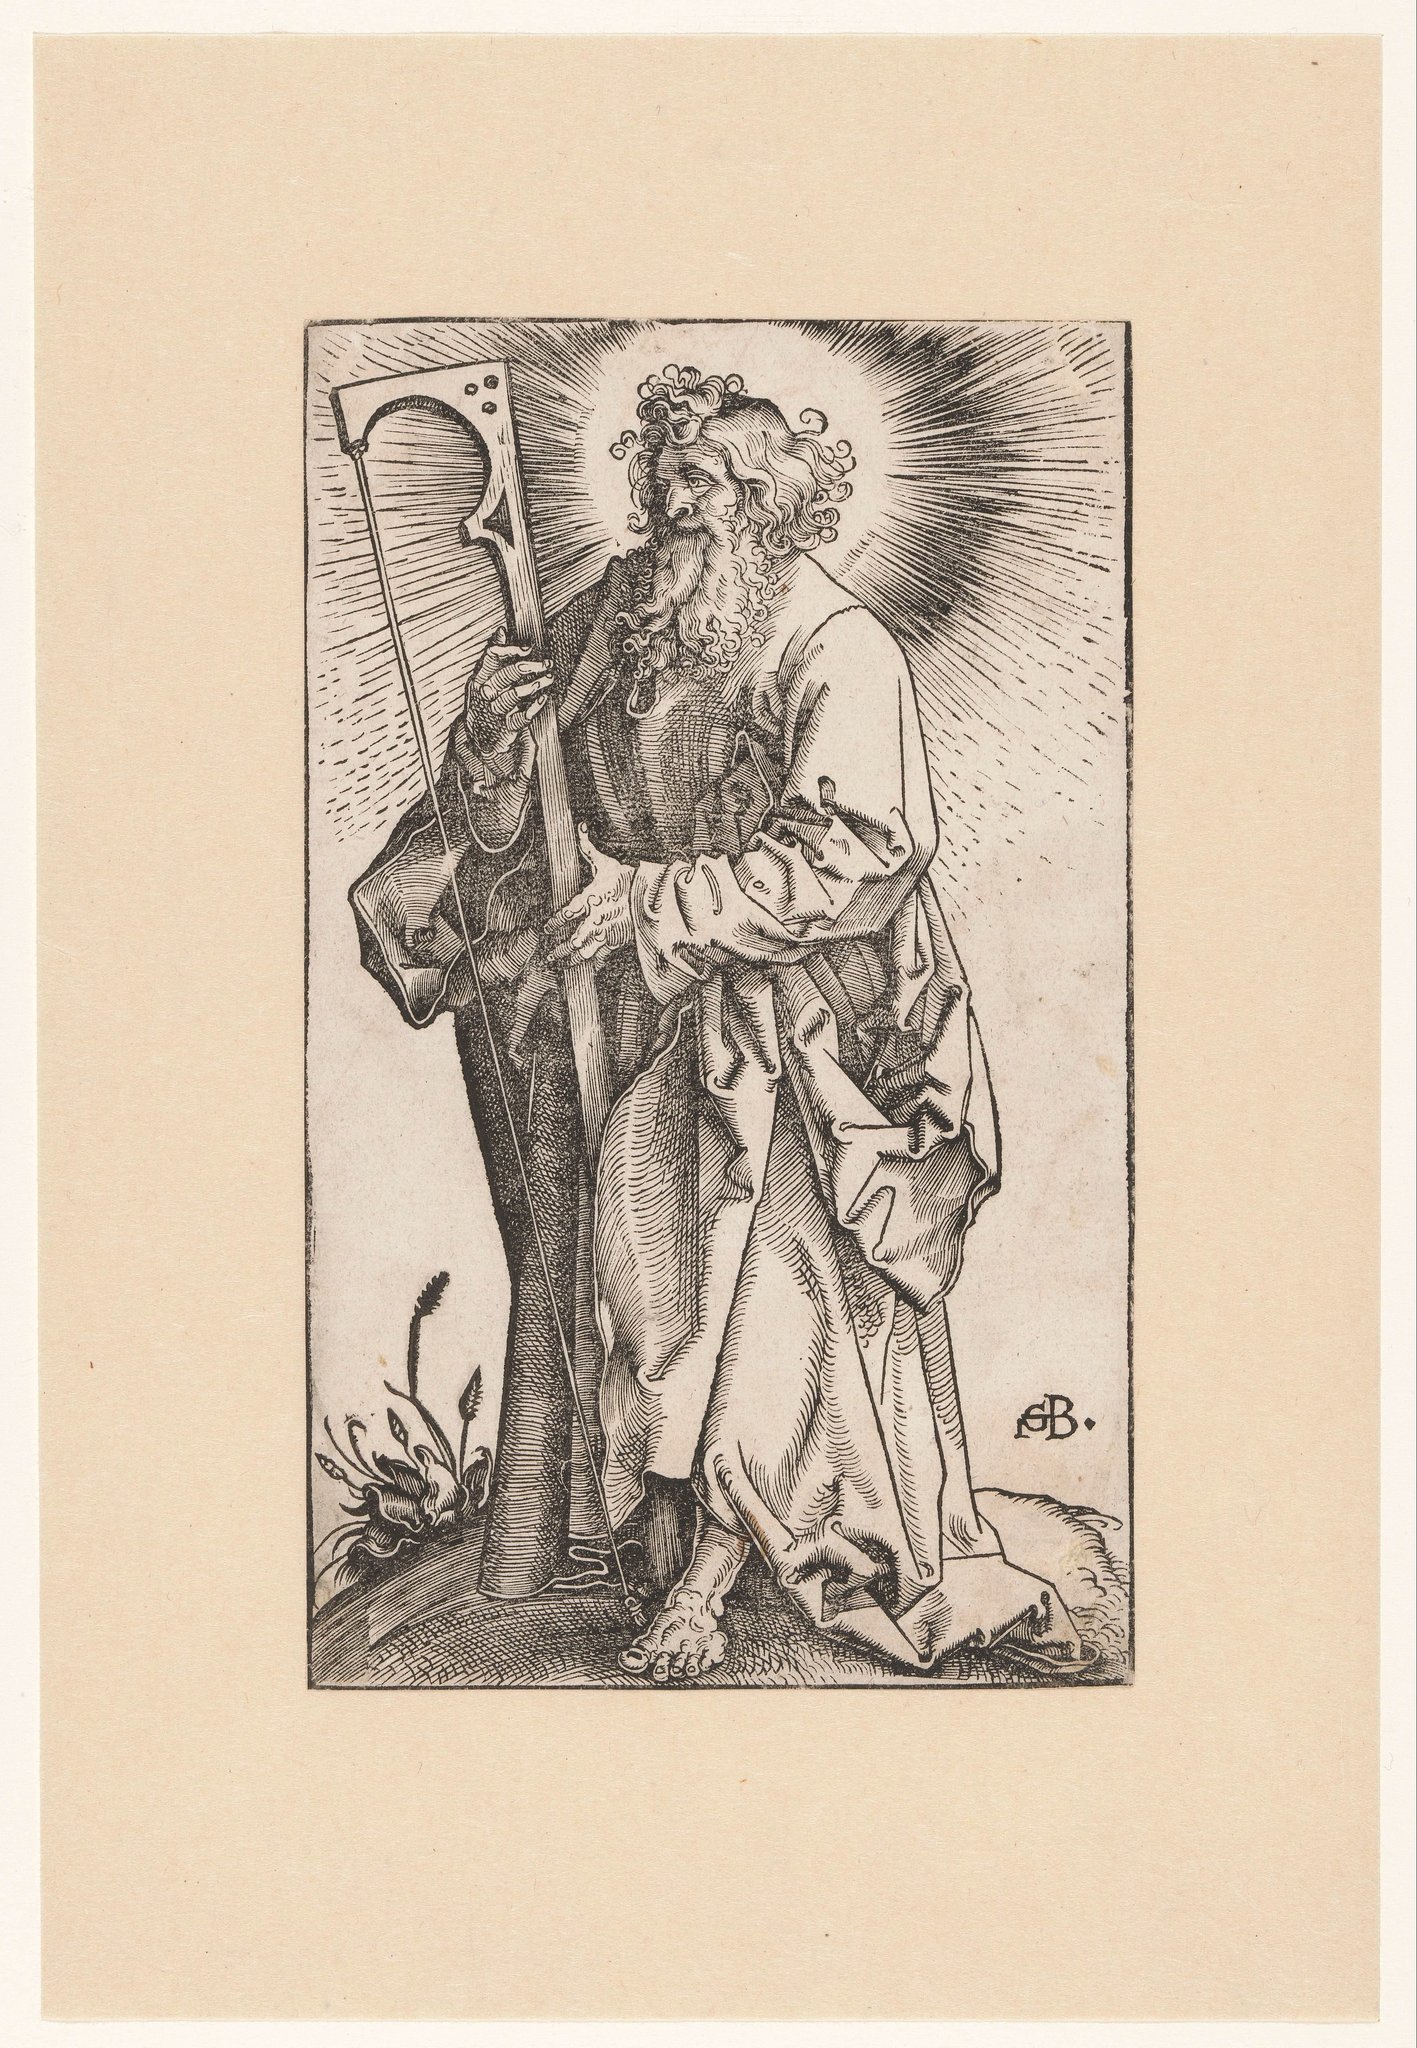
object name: print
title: Christus en de Apostelen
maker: hans baldung grien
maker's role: draughtsman, print maker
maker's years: 1484-1545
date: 1519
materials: paper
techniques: woodcut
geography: straatsburg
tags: the apostle james the less, first bishop of jerusalem; possible attributes: book, fuller's club, scroll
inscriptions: collector's mark: Lugt 2228a